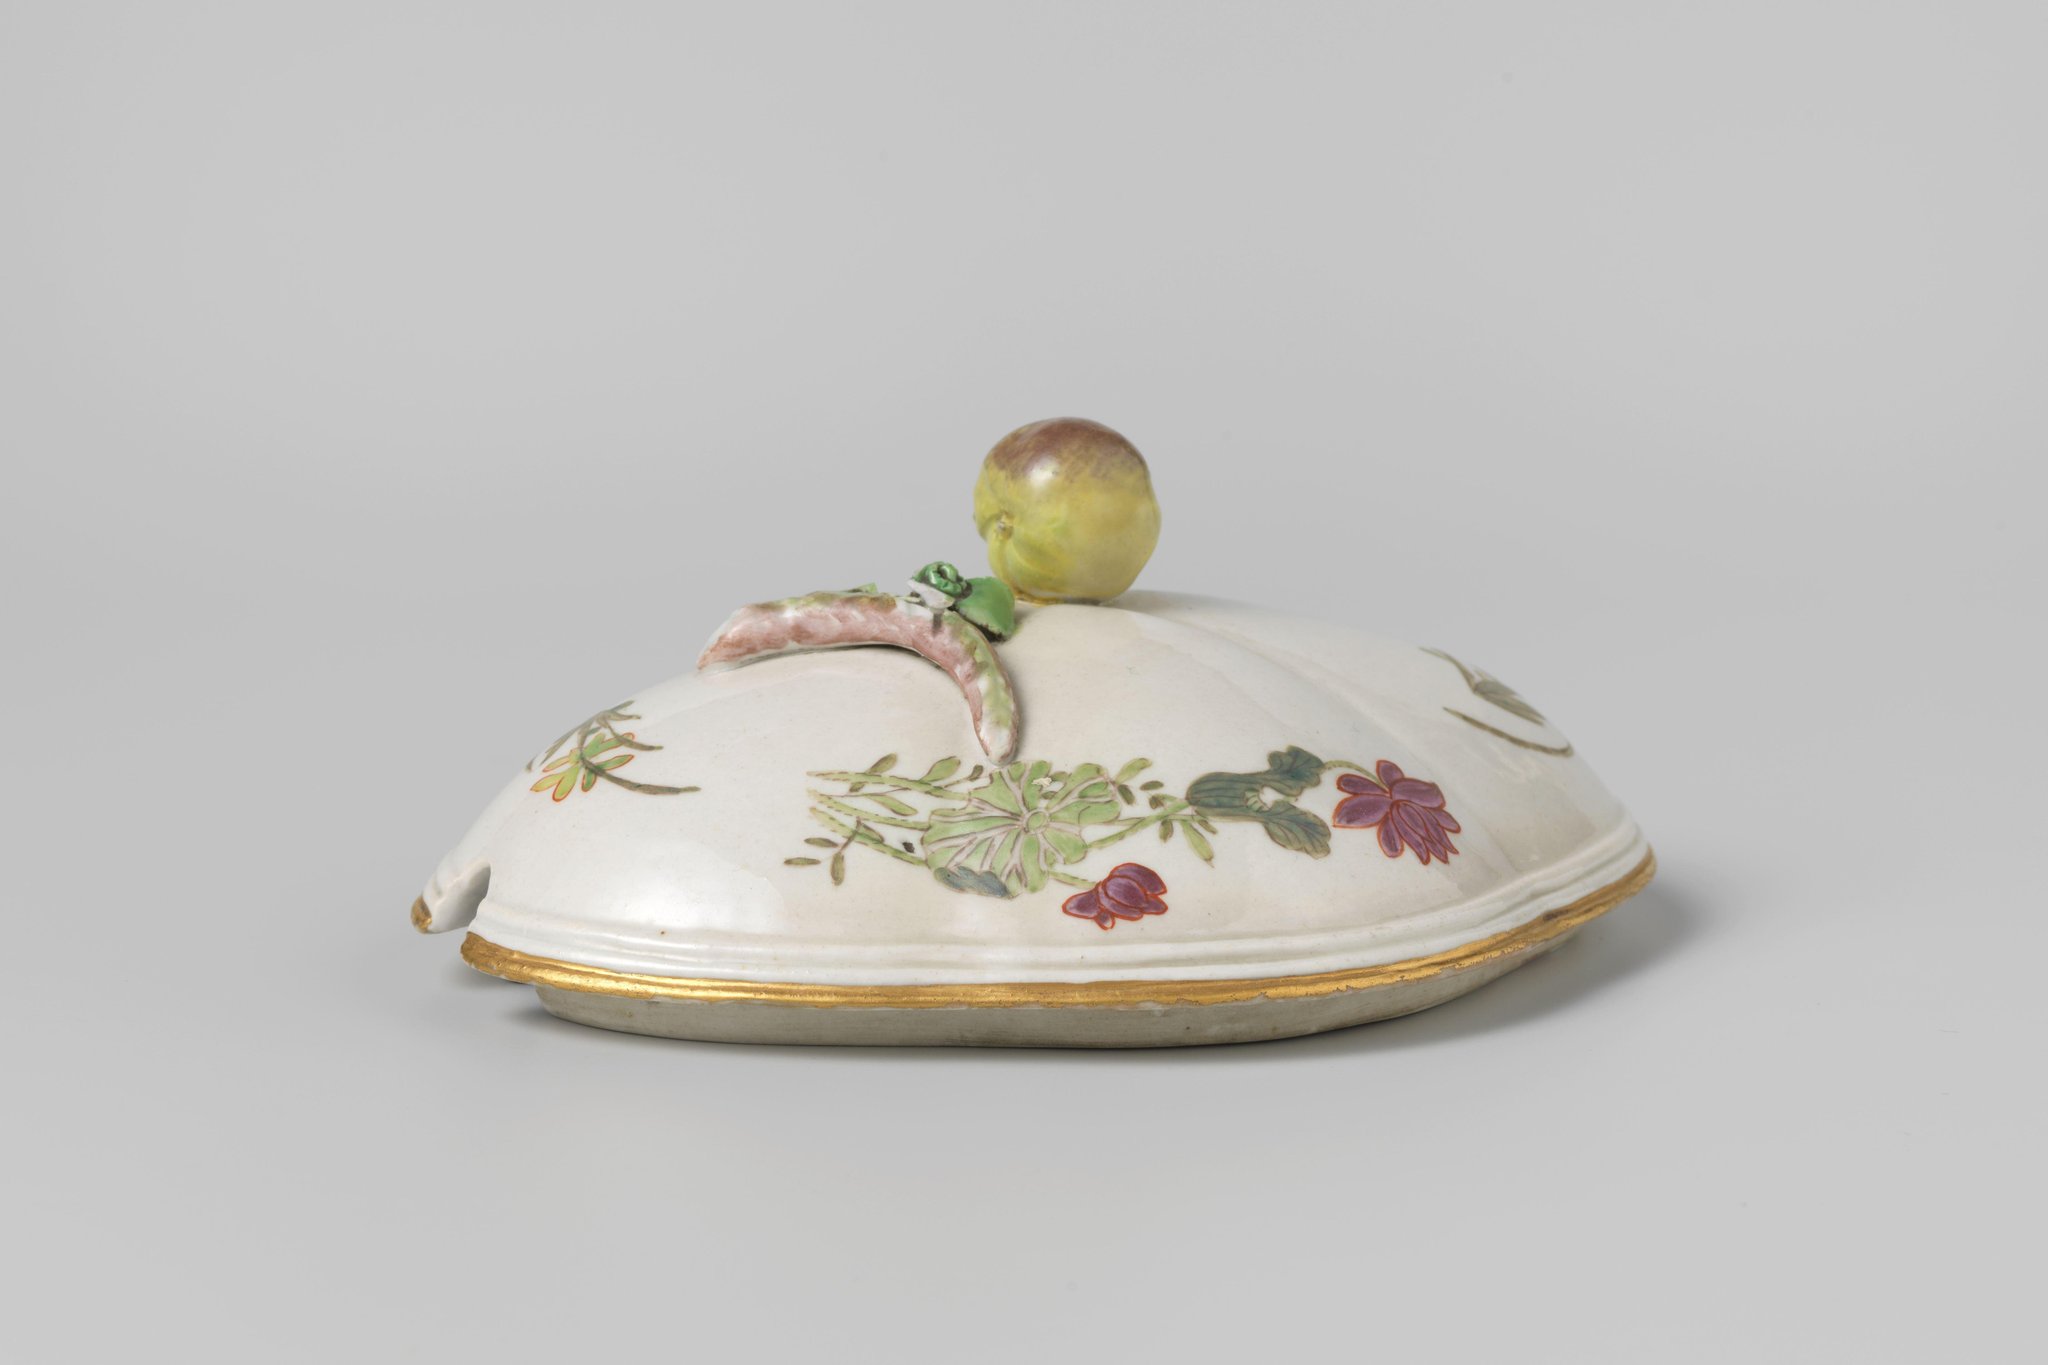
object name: lid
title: Deksel van terrine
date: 1759-1771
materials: porcelain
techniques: painted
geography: weesp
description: Deksel van terrine . Op het deksel een vrucht als knop.